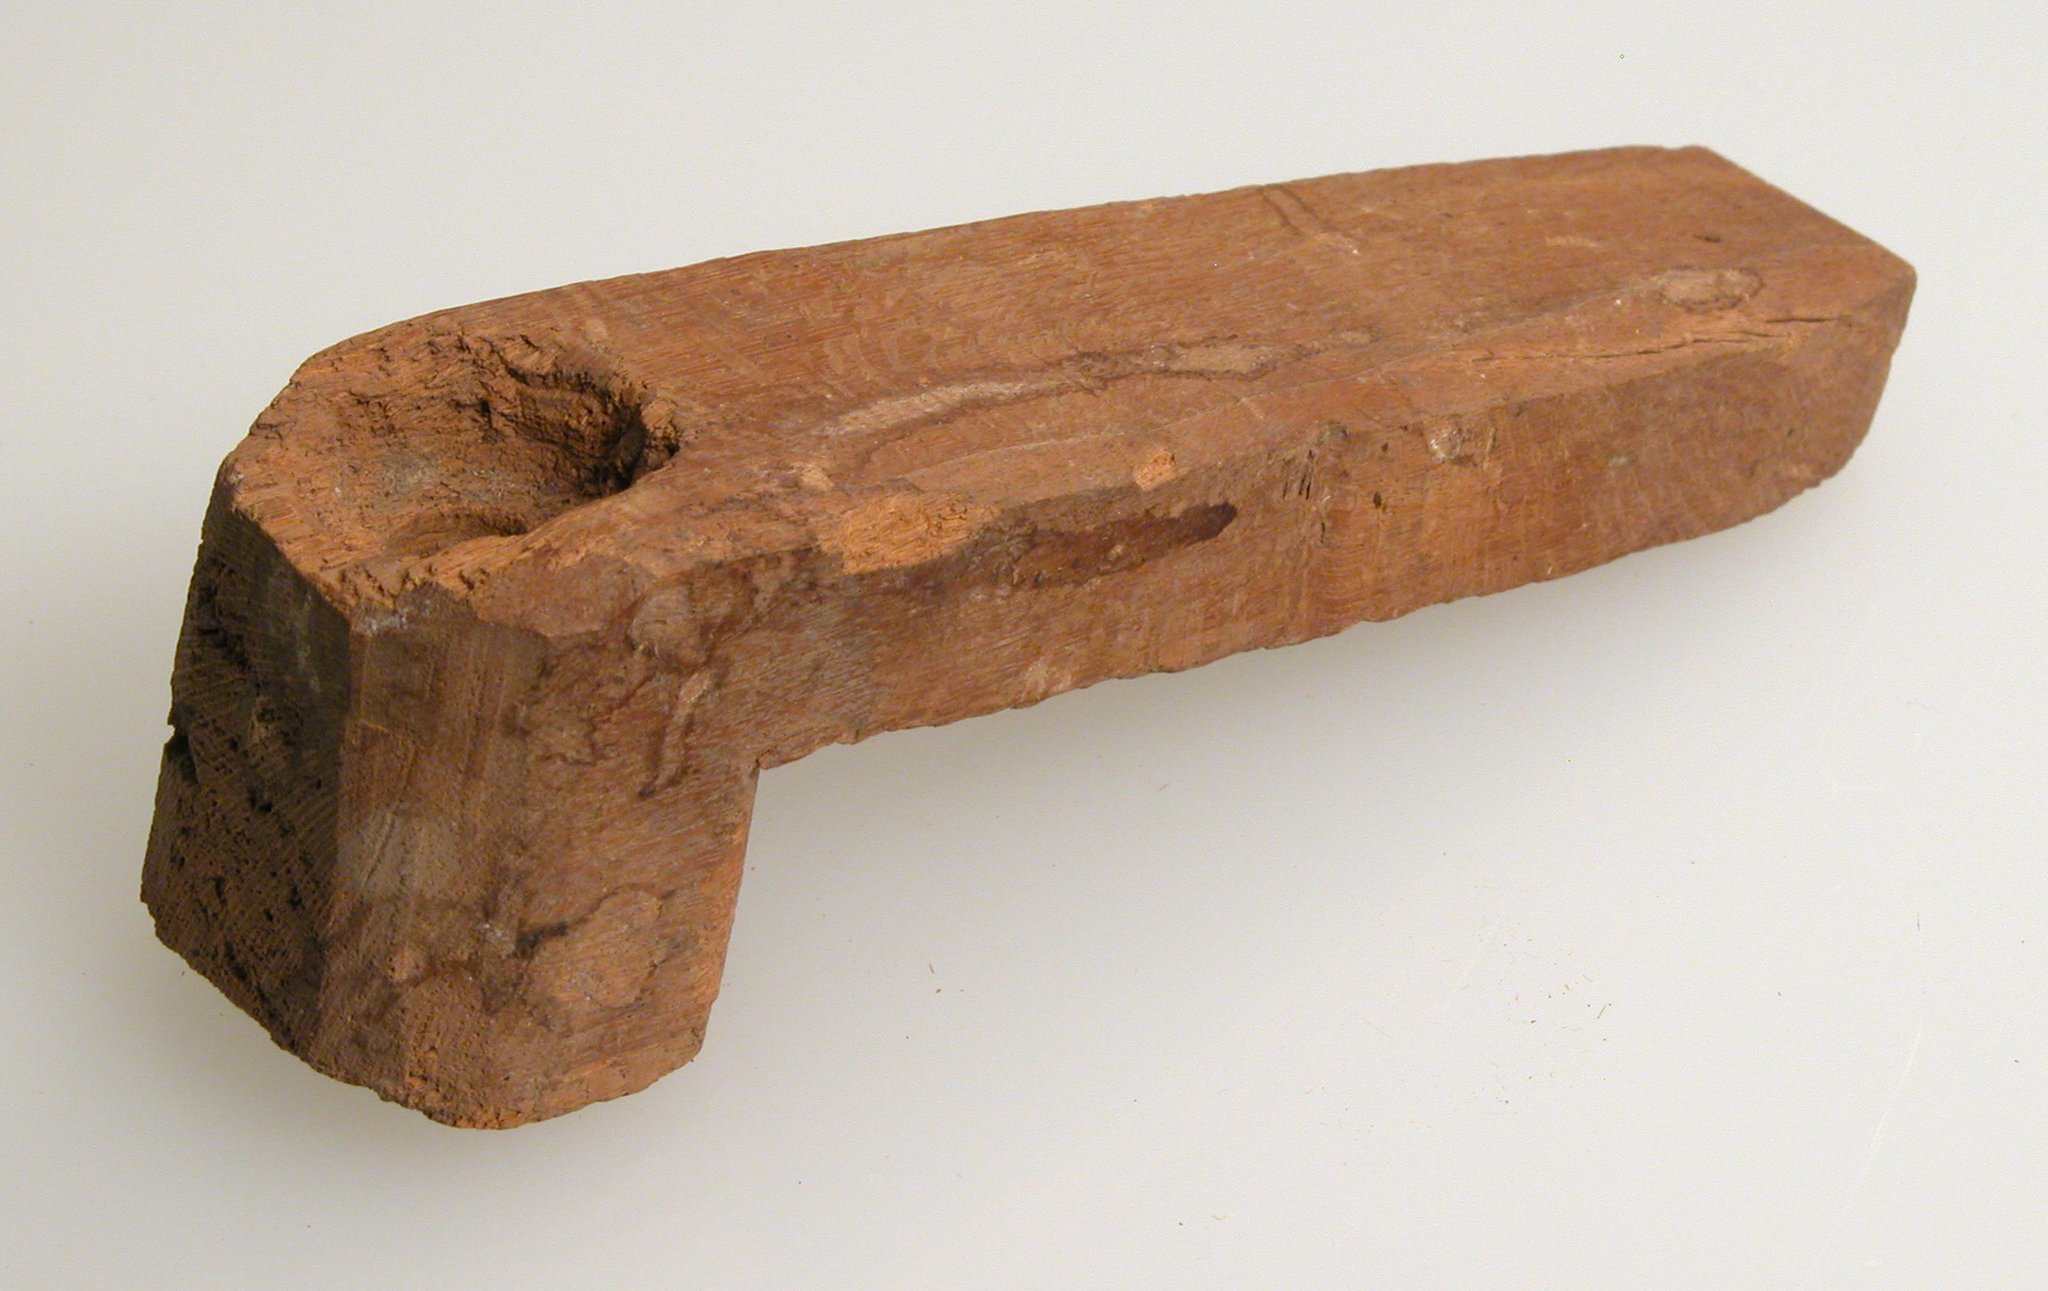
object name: door catch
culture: coptic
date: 580-640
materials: wood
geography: egypt